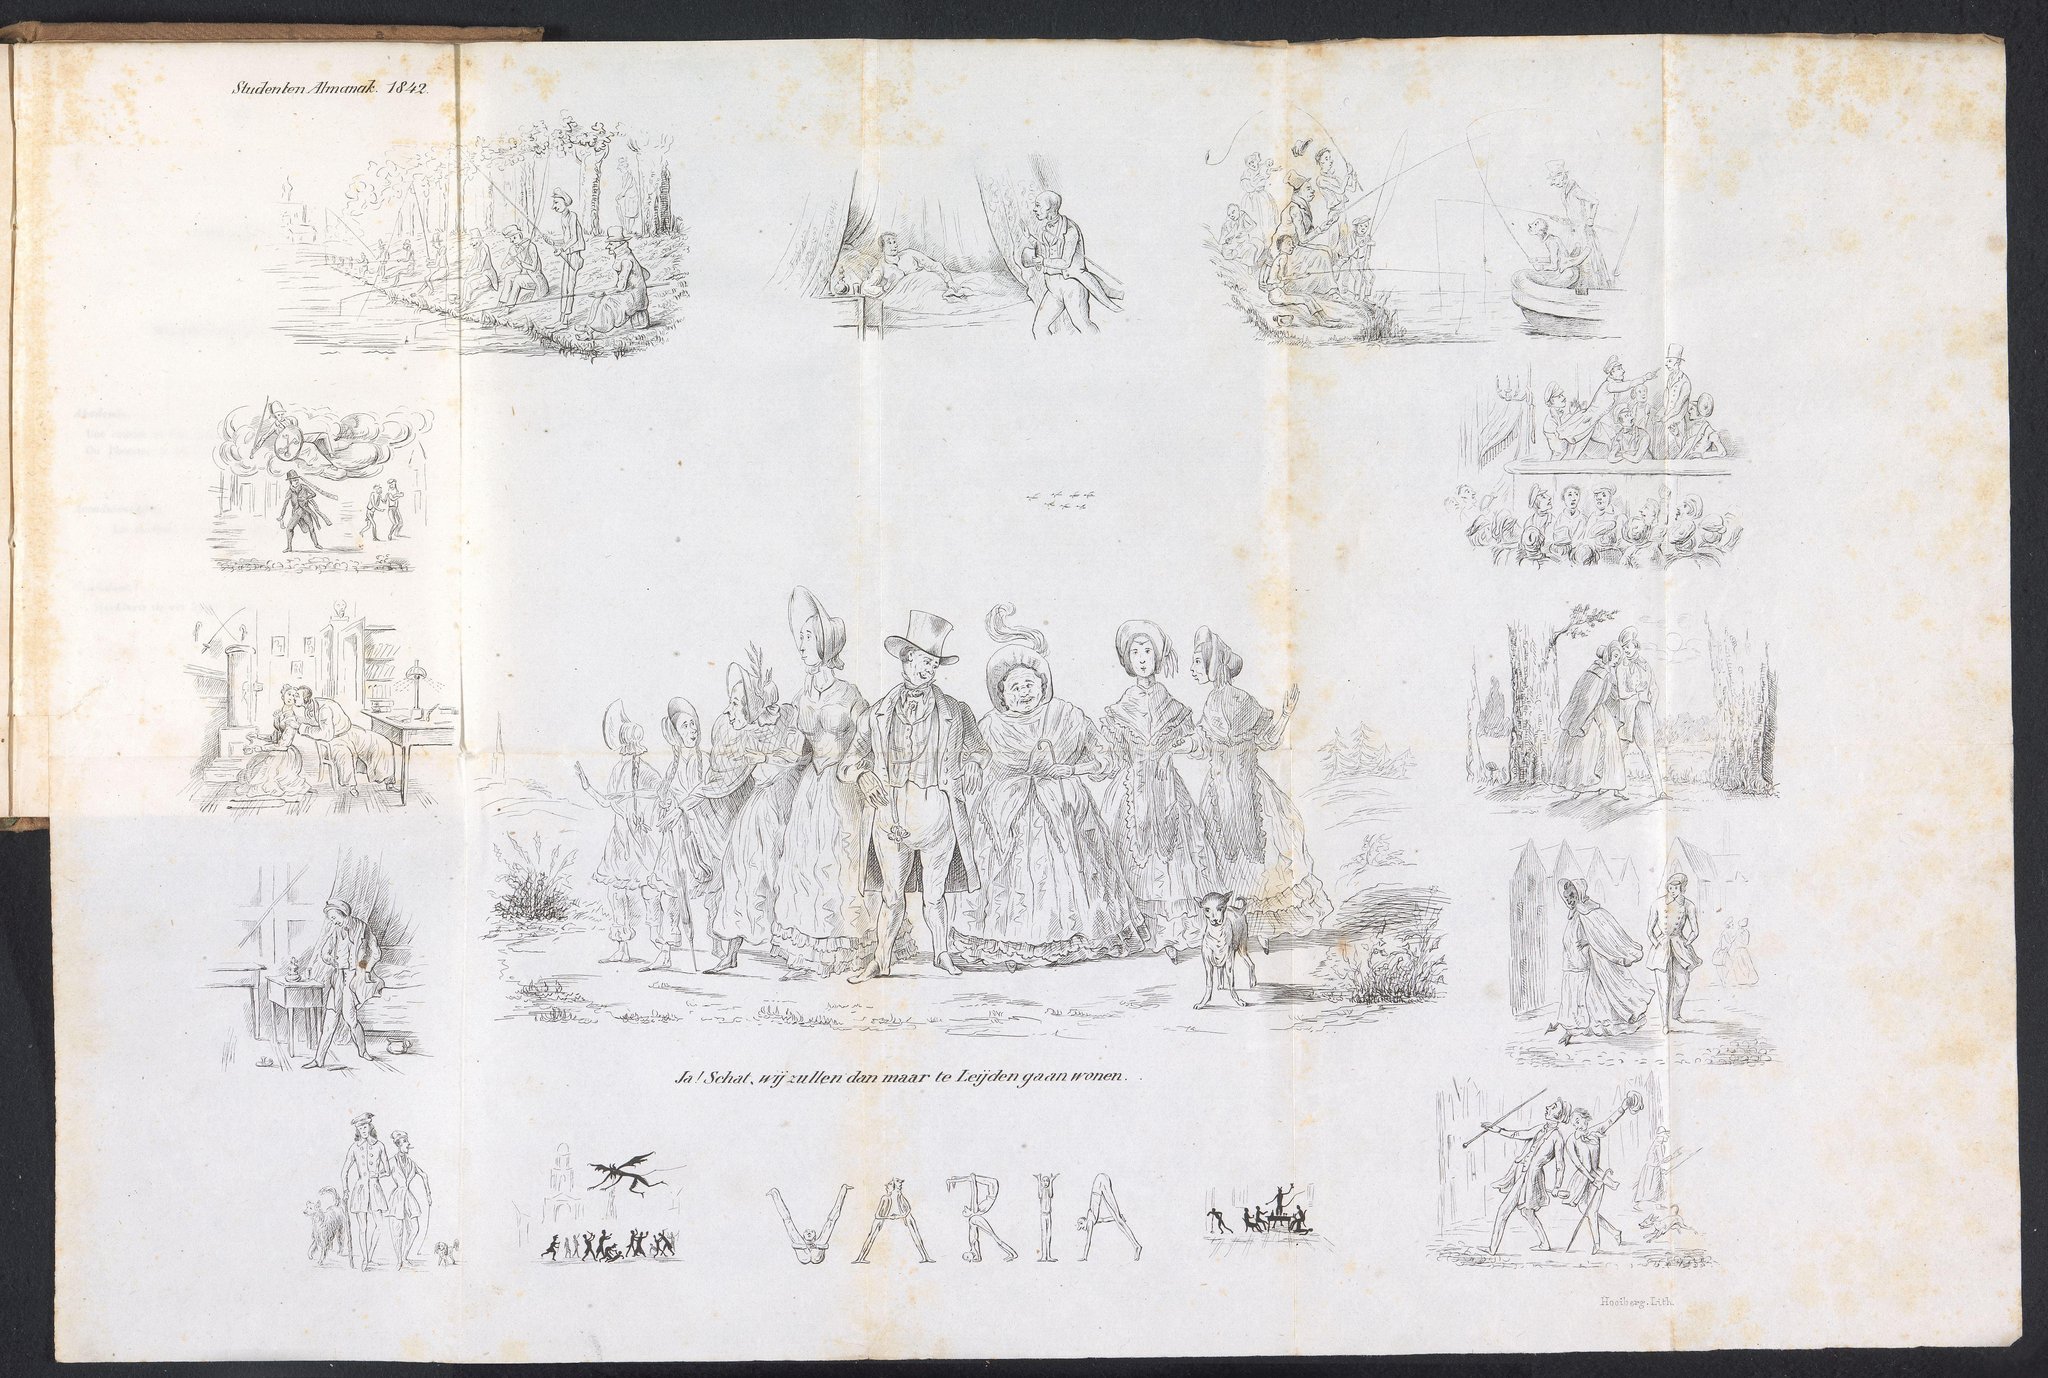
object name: cartoon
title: Spotprent in Leidse studentenalmanak, 1842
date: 1842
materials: paper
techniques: lithograph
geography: netherlands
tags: student life, leiden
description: Centraal een gezin met zes dochters die naar Leiden gaan verhuizen. Omringd door veertien kleine scènes uit het Leidse studentenleven. Spotprent in de studentenalmanak van de Universiteit van Leiden van het jaar 1842.